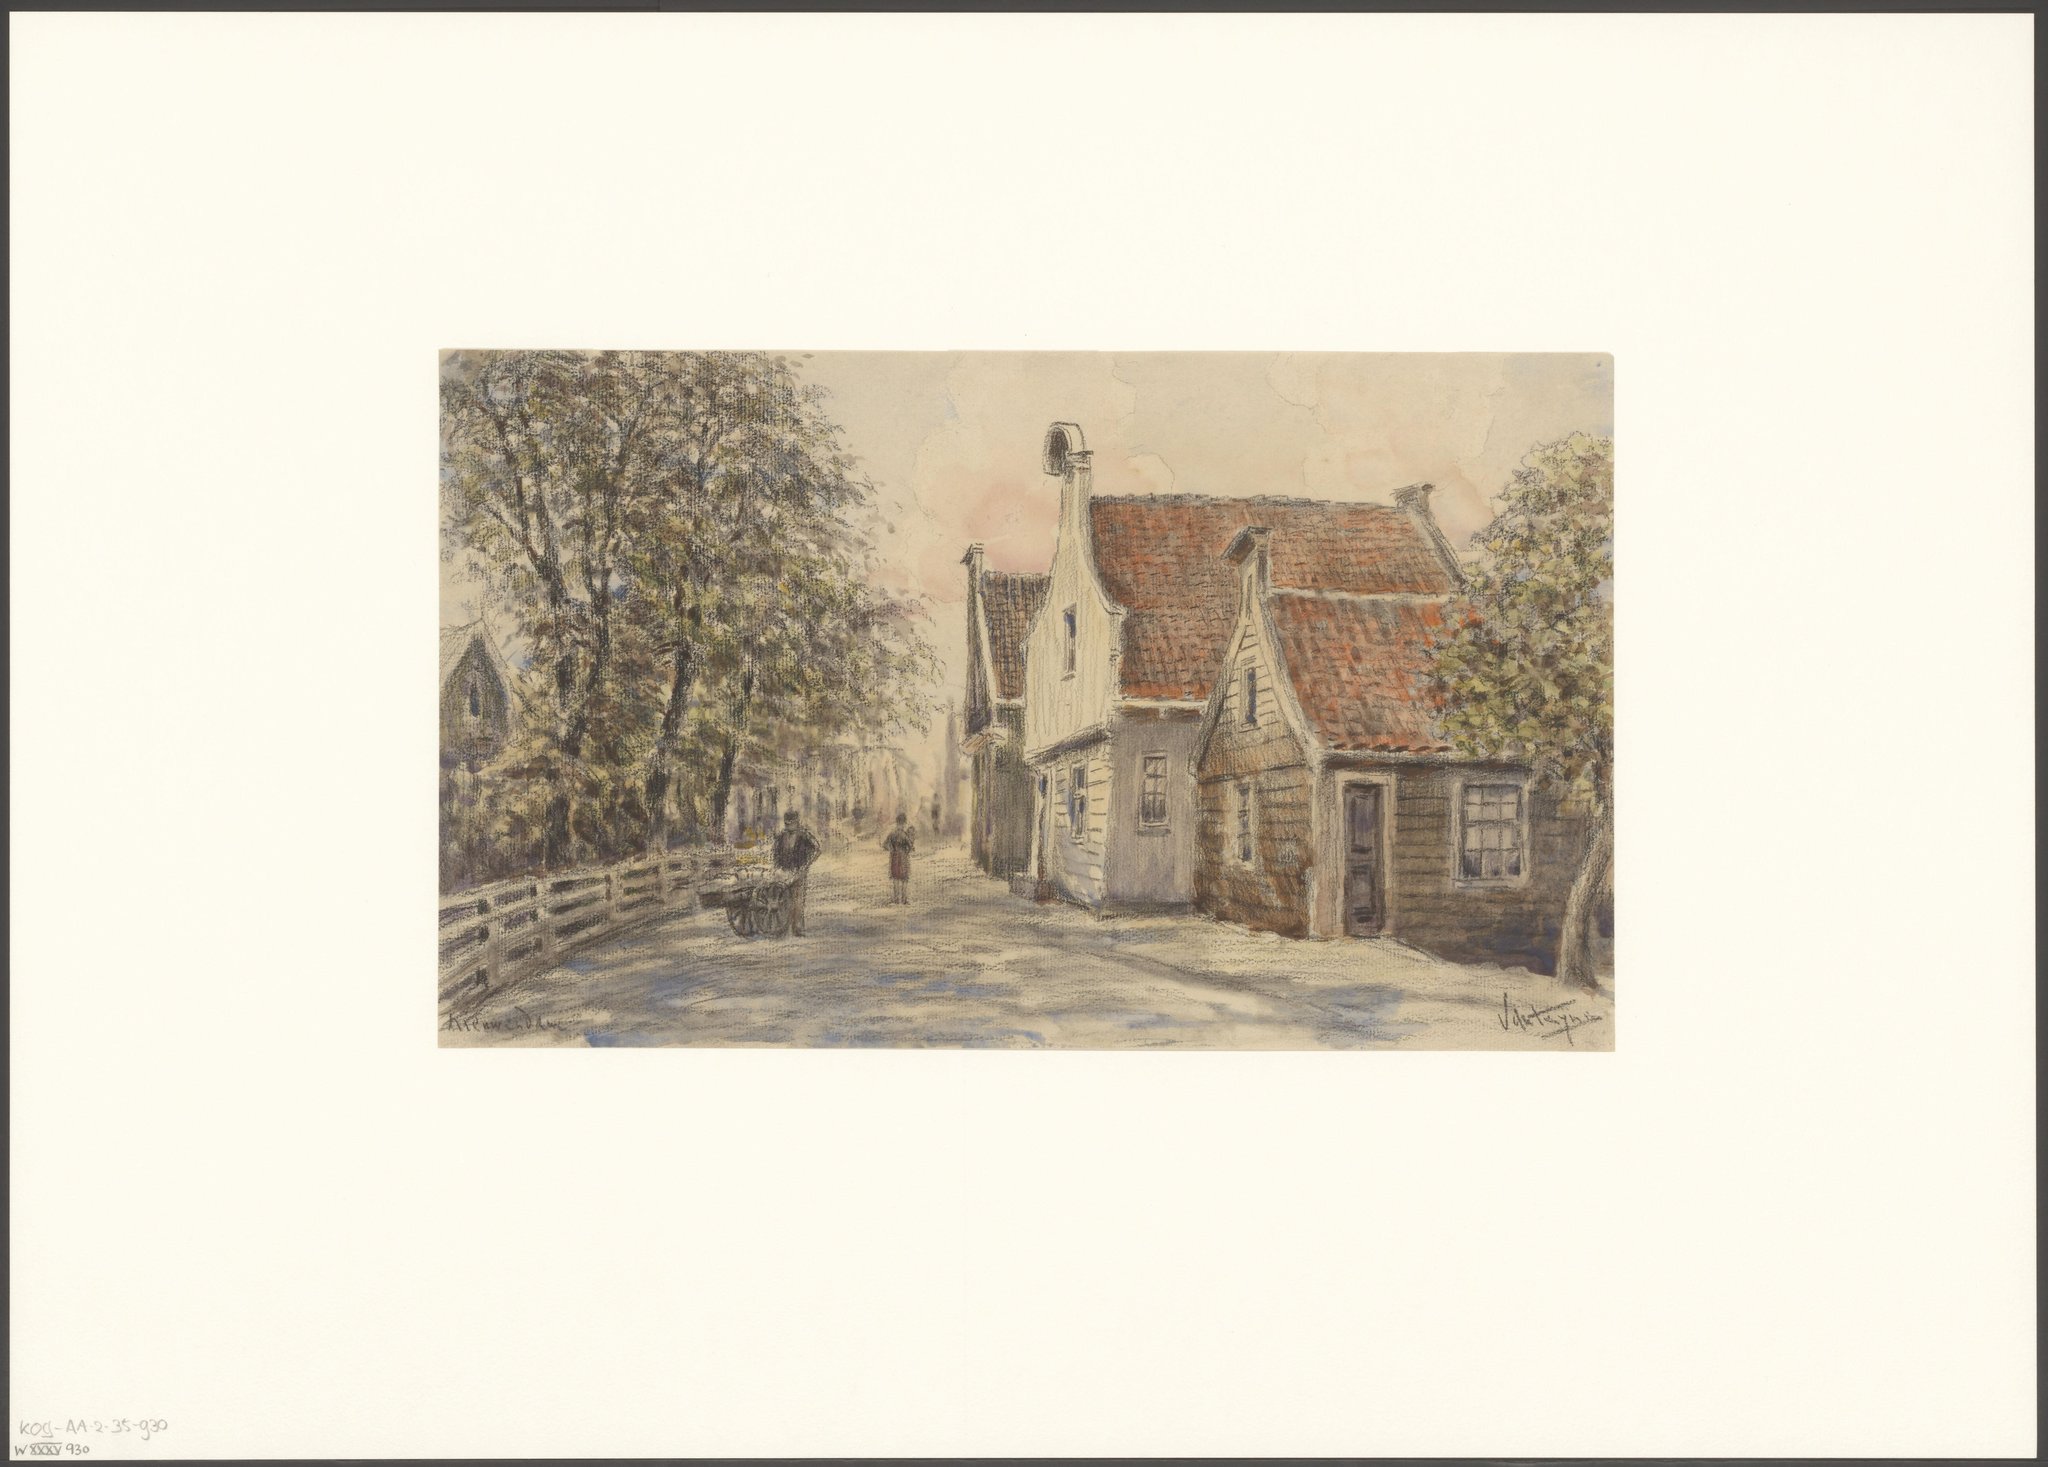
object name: drawing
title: Gezicht op de Nieuwendammerdijk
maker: anthonie van teijn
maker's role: draughtsman, painter, print maker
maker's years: 1863-1943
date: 1907-1928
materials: chalk, paper, watercolor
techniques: brush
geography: amsterdam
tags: village, the usual house or row of houses, street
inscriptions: signature: ‘VanTeyne’, collector's mark: Lugt 800a, inscription: ‘Nieuwendam.’, inscription: ‘Nieuwen dam Nieuwen (...) Teyn. Juli 1928.’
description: Tekening binnen de Atlas Van Eck ingedeeld op wijknummer 35.